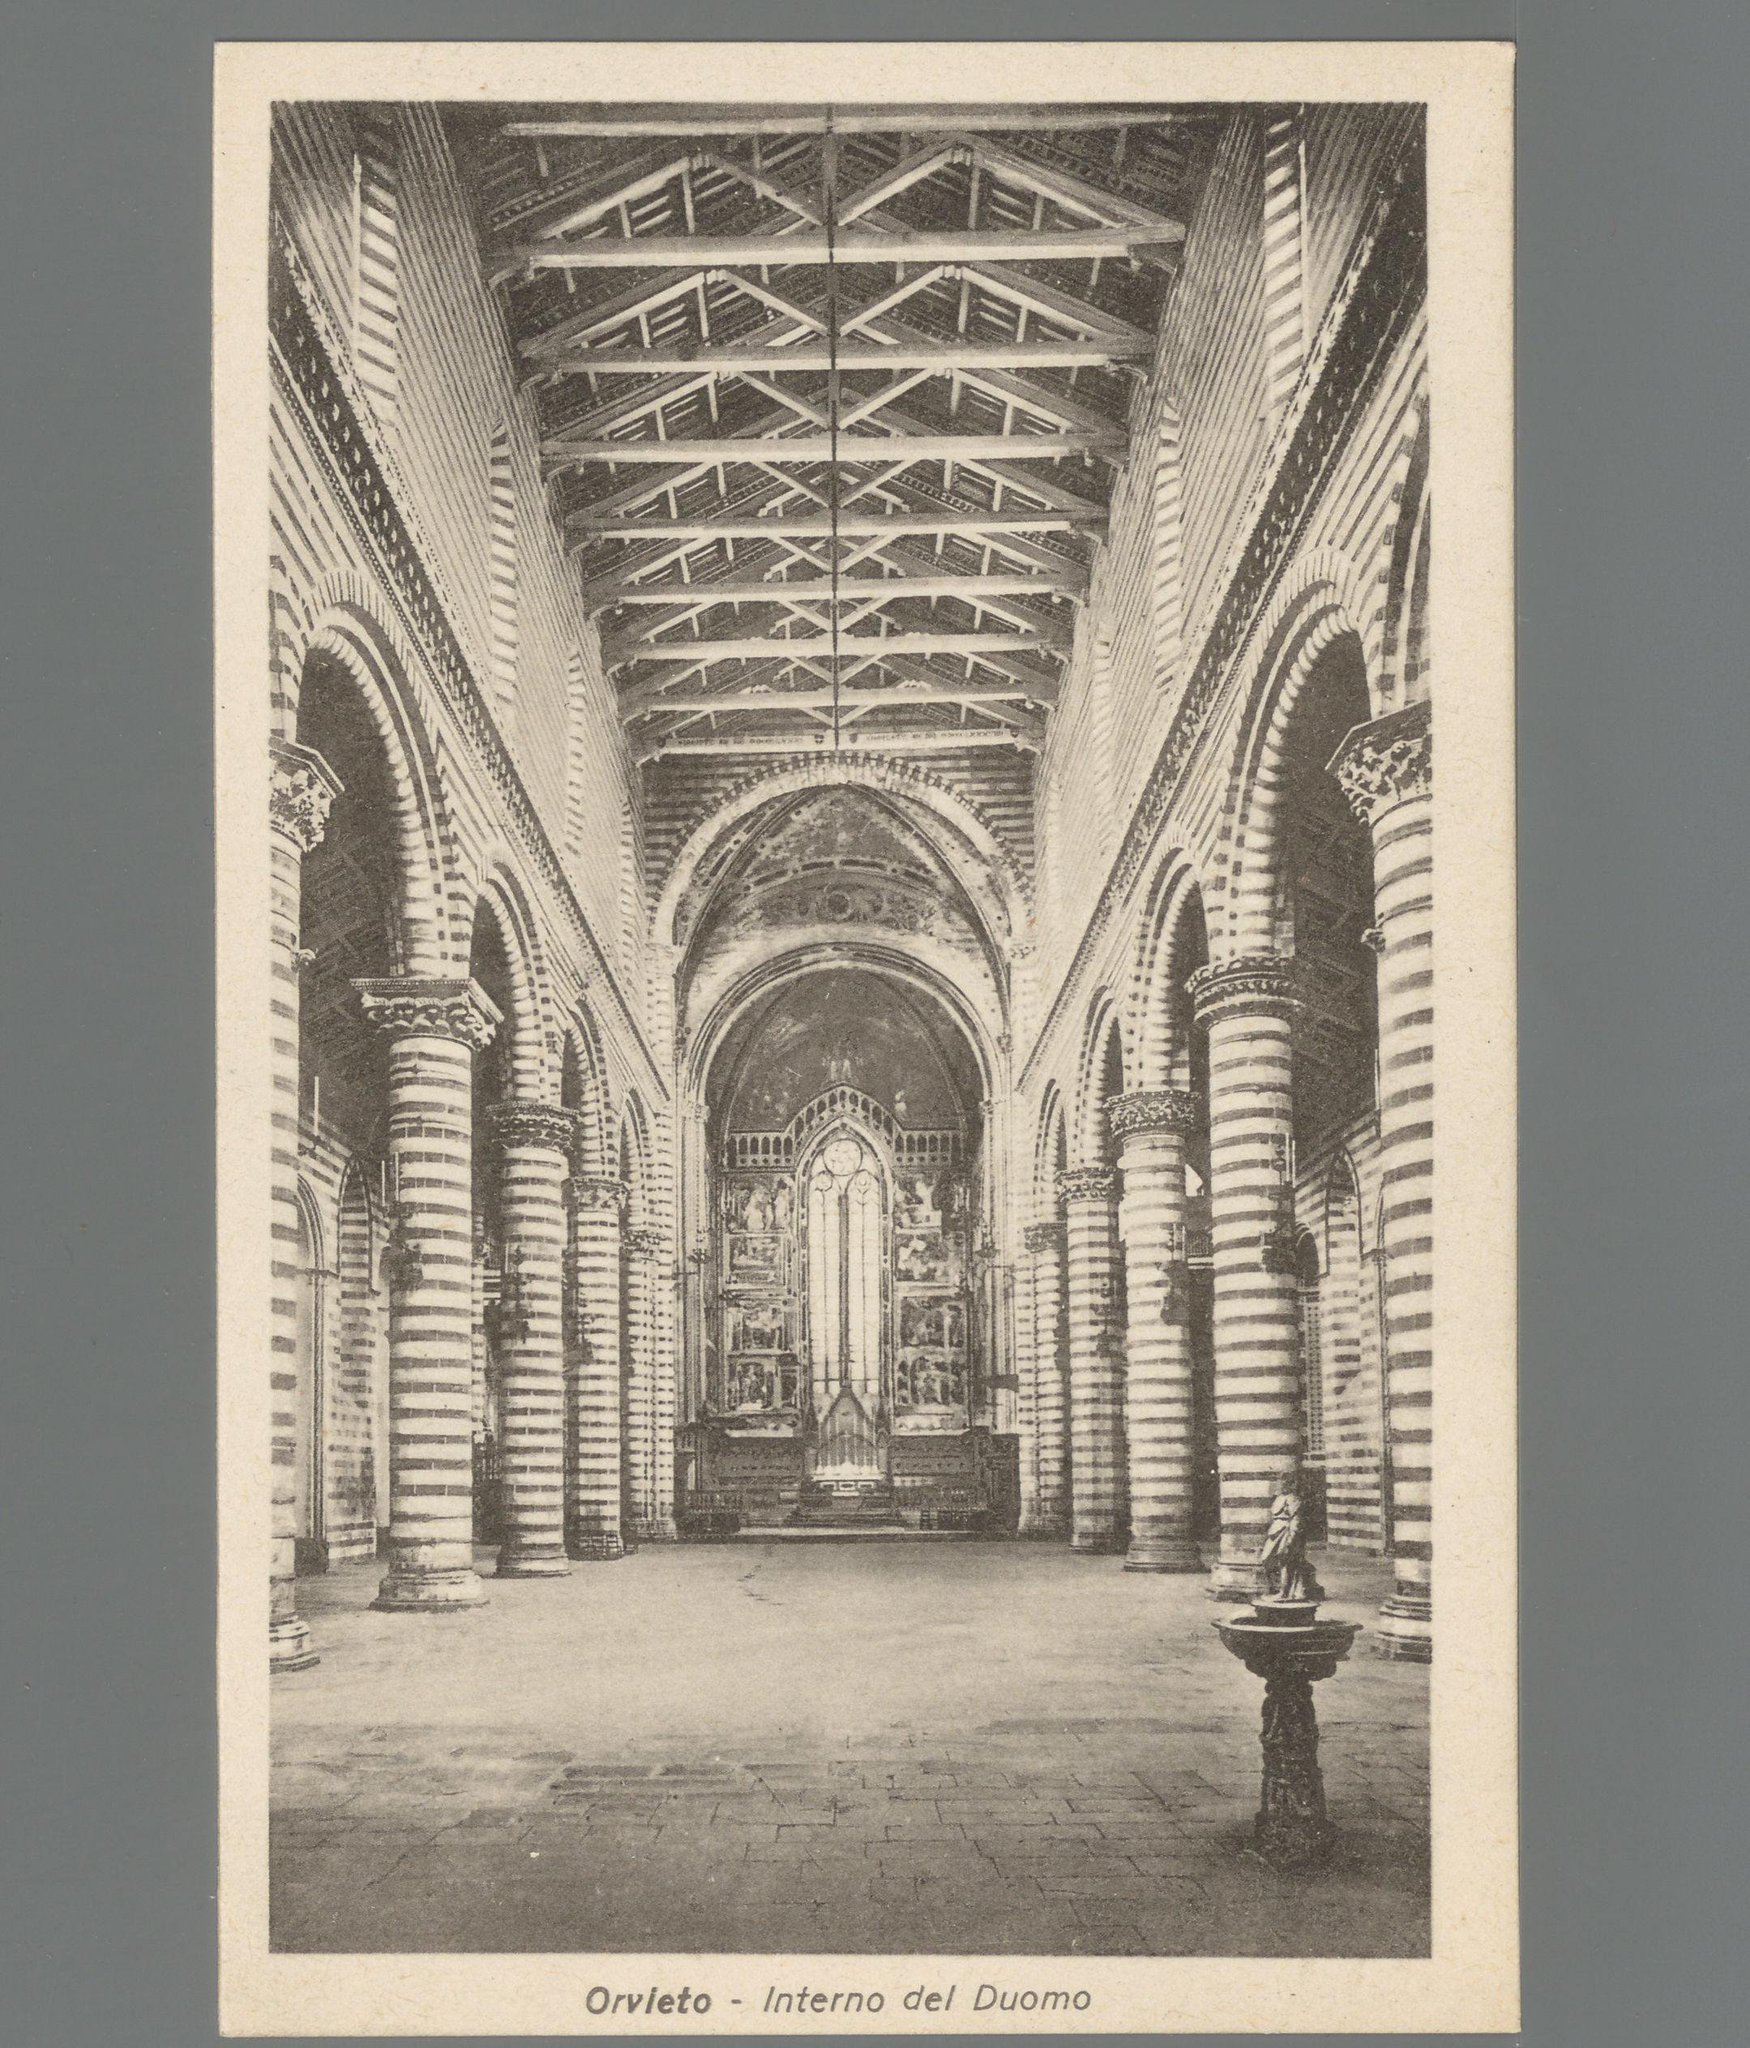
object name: photomechanical print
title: Orvieto. Interno del Duomo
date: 1906-1930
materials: cardboard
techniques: photograph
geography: orvieto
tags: church (exterior)